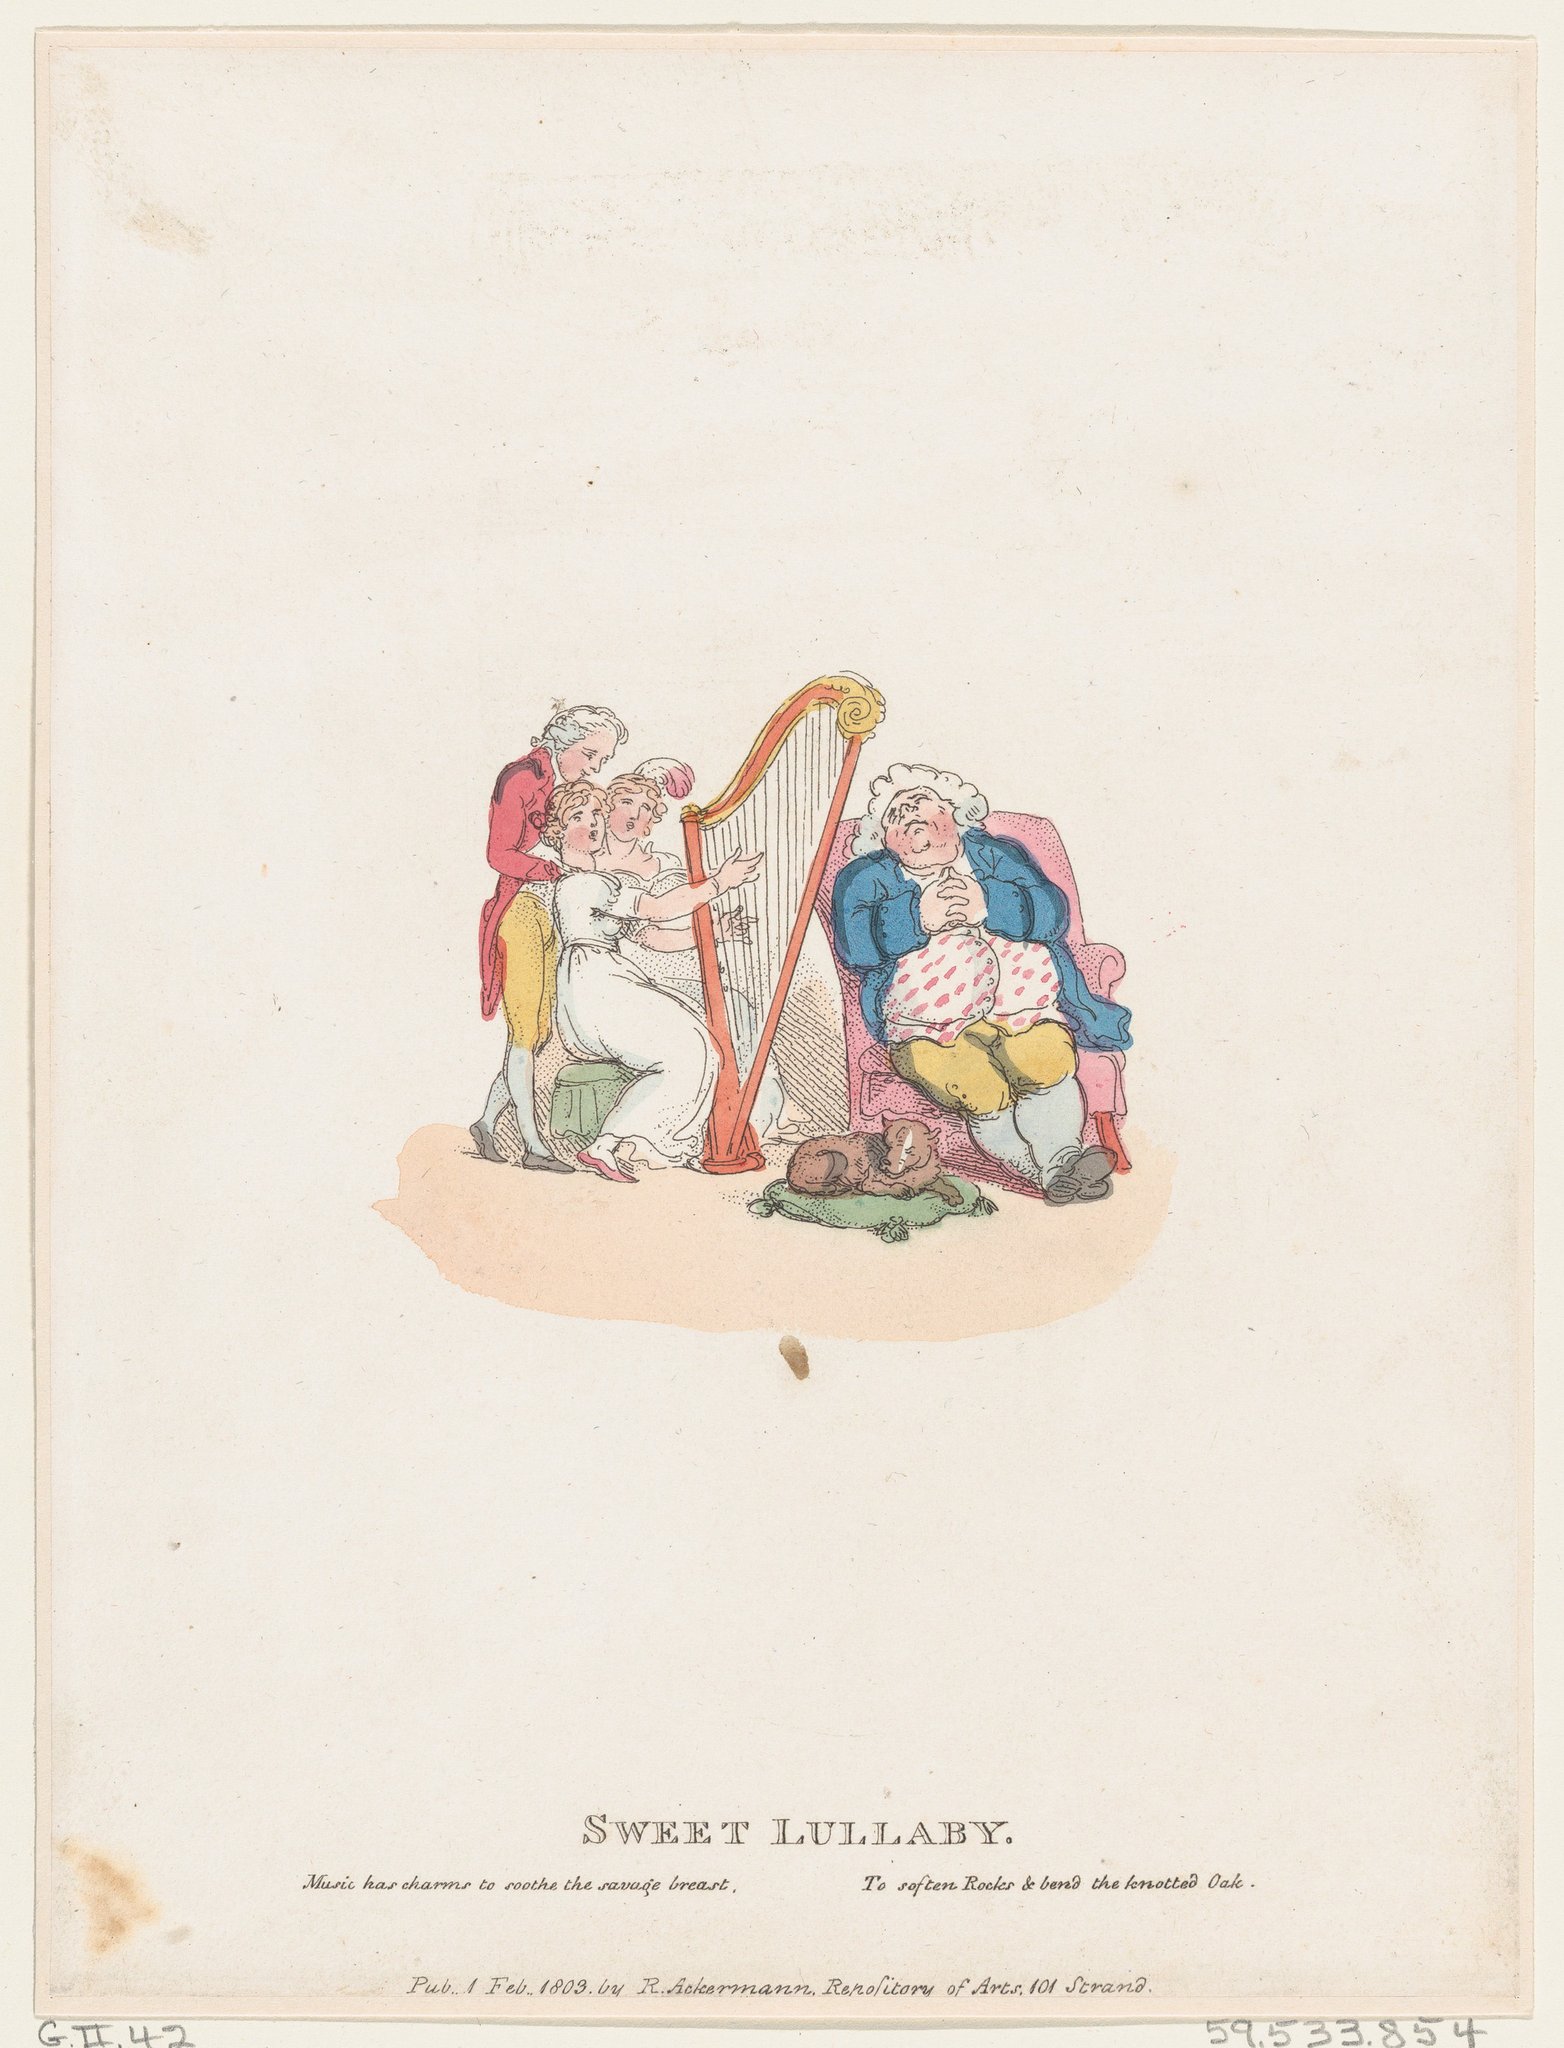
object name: print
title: Sweet Lullaby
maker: thomas rowlandson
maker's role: artist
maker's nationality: british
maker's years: 1757-1827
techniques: etching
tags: satire,men,women,harps,dogs,musicians